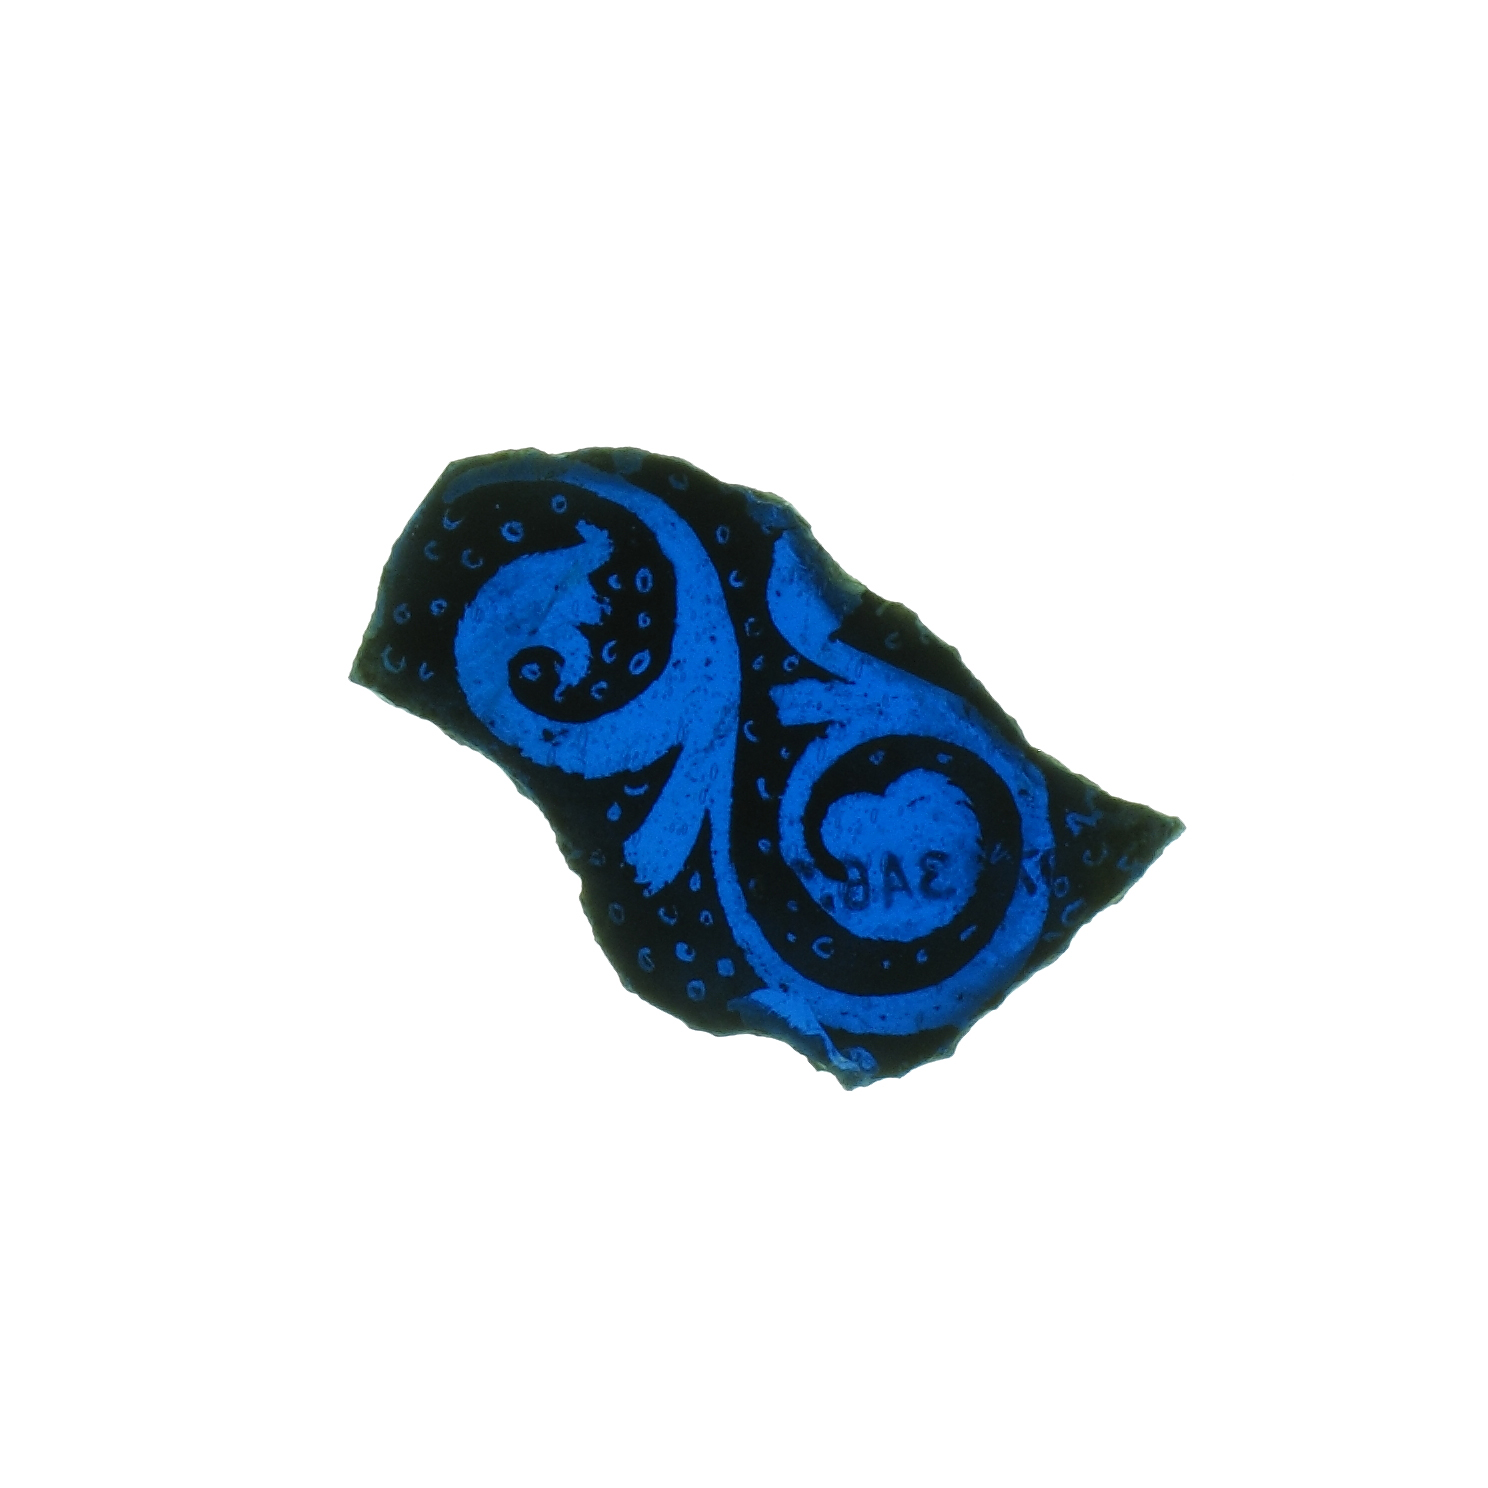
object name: fragment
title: Glass Fragment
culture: french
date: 1101-1400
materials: glass, metal, paint